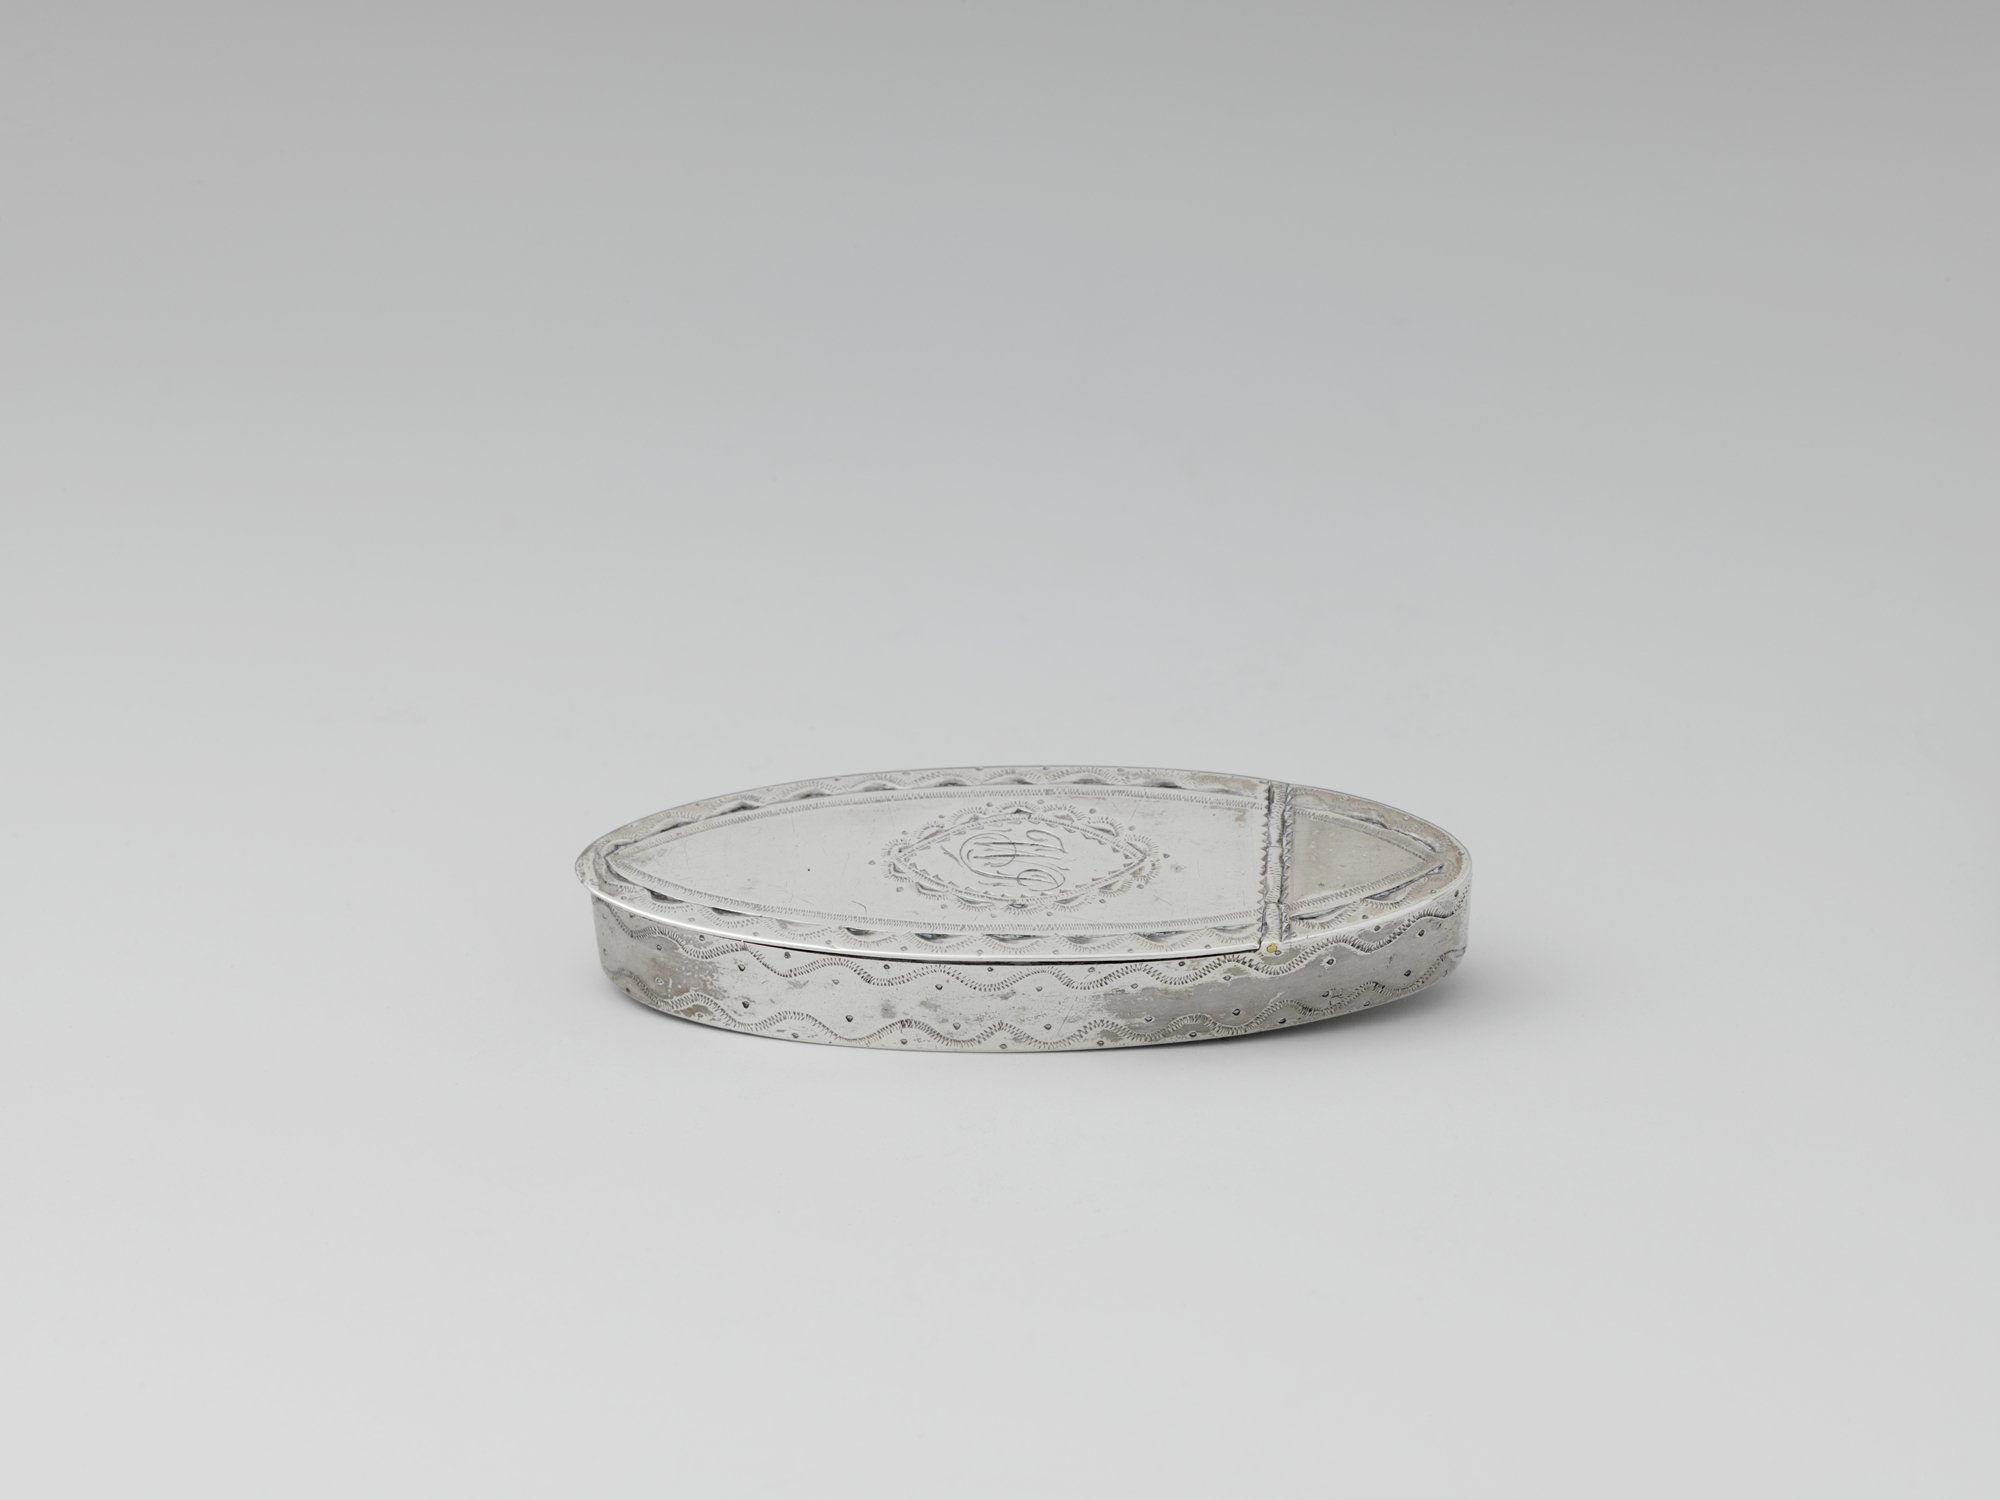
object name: box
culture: american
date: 1800-1830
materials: silver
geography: united states